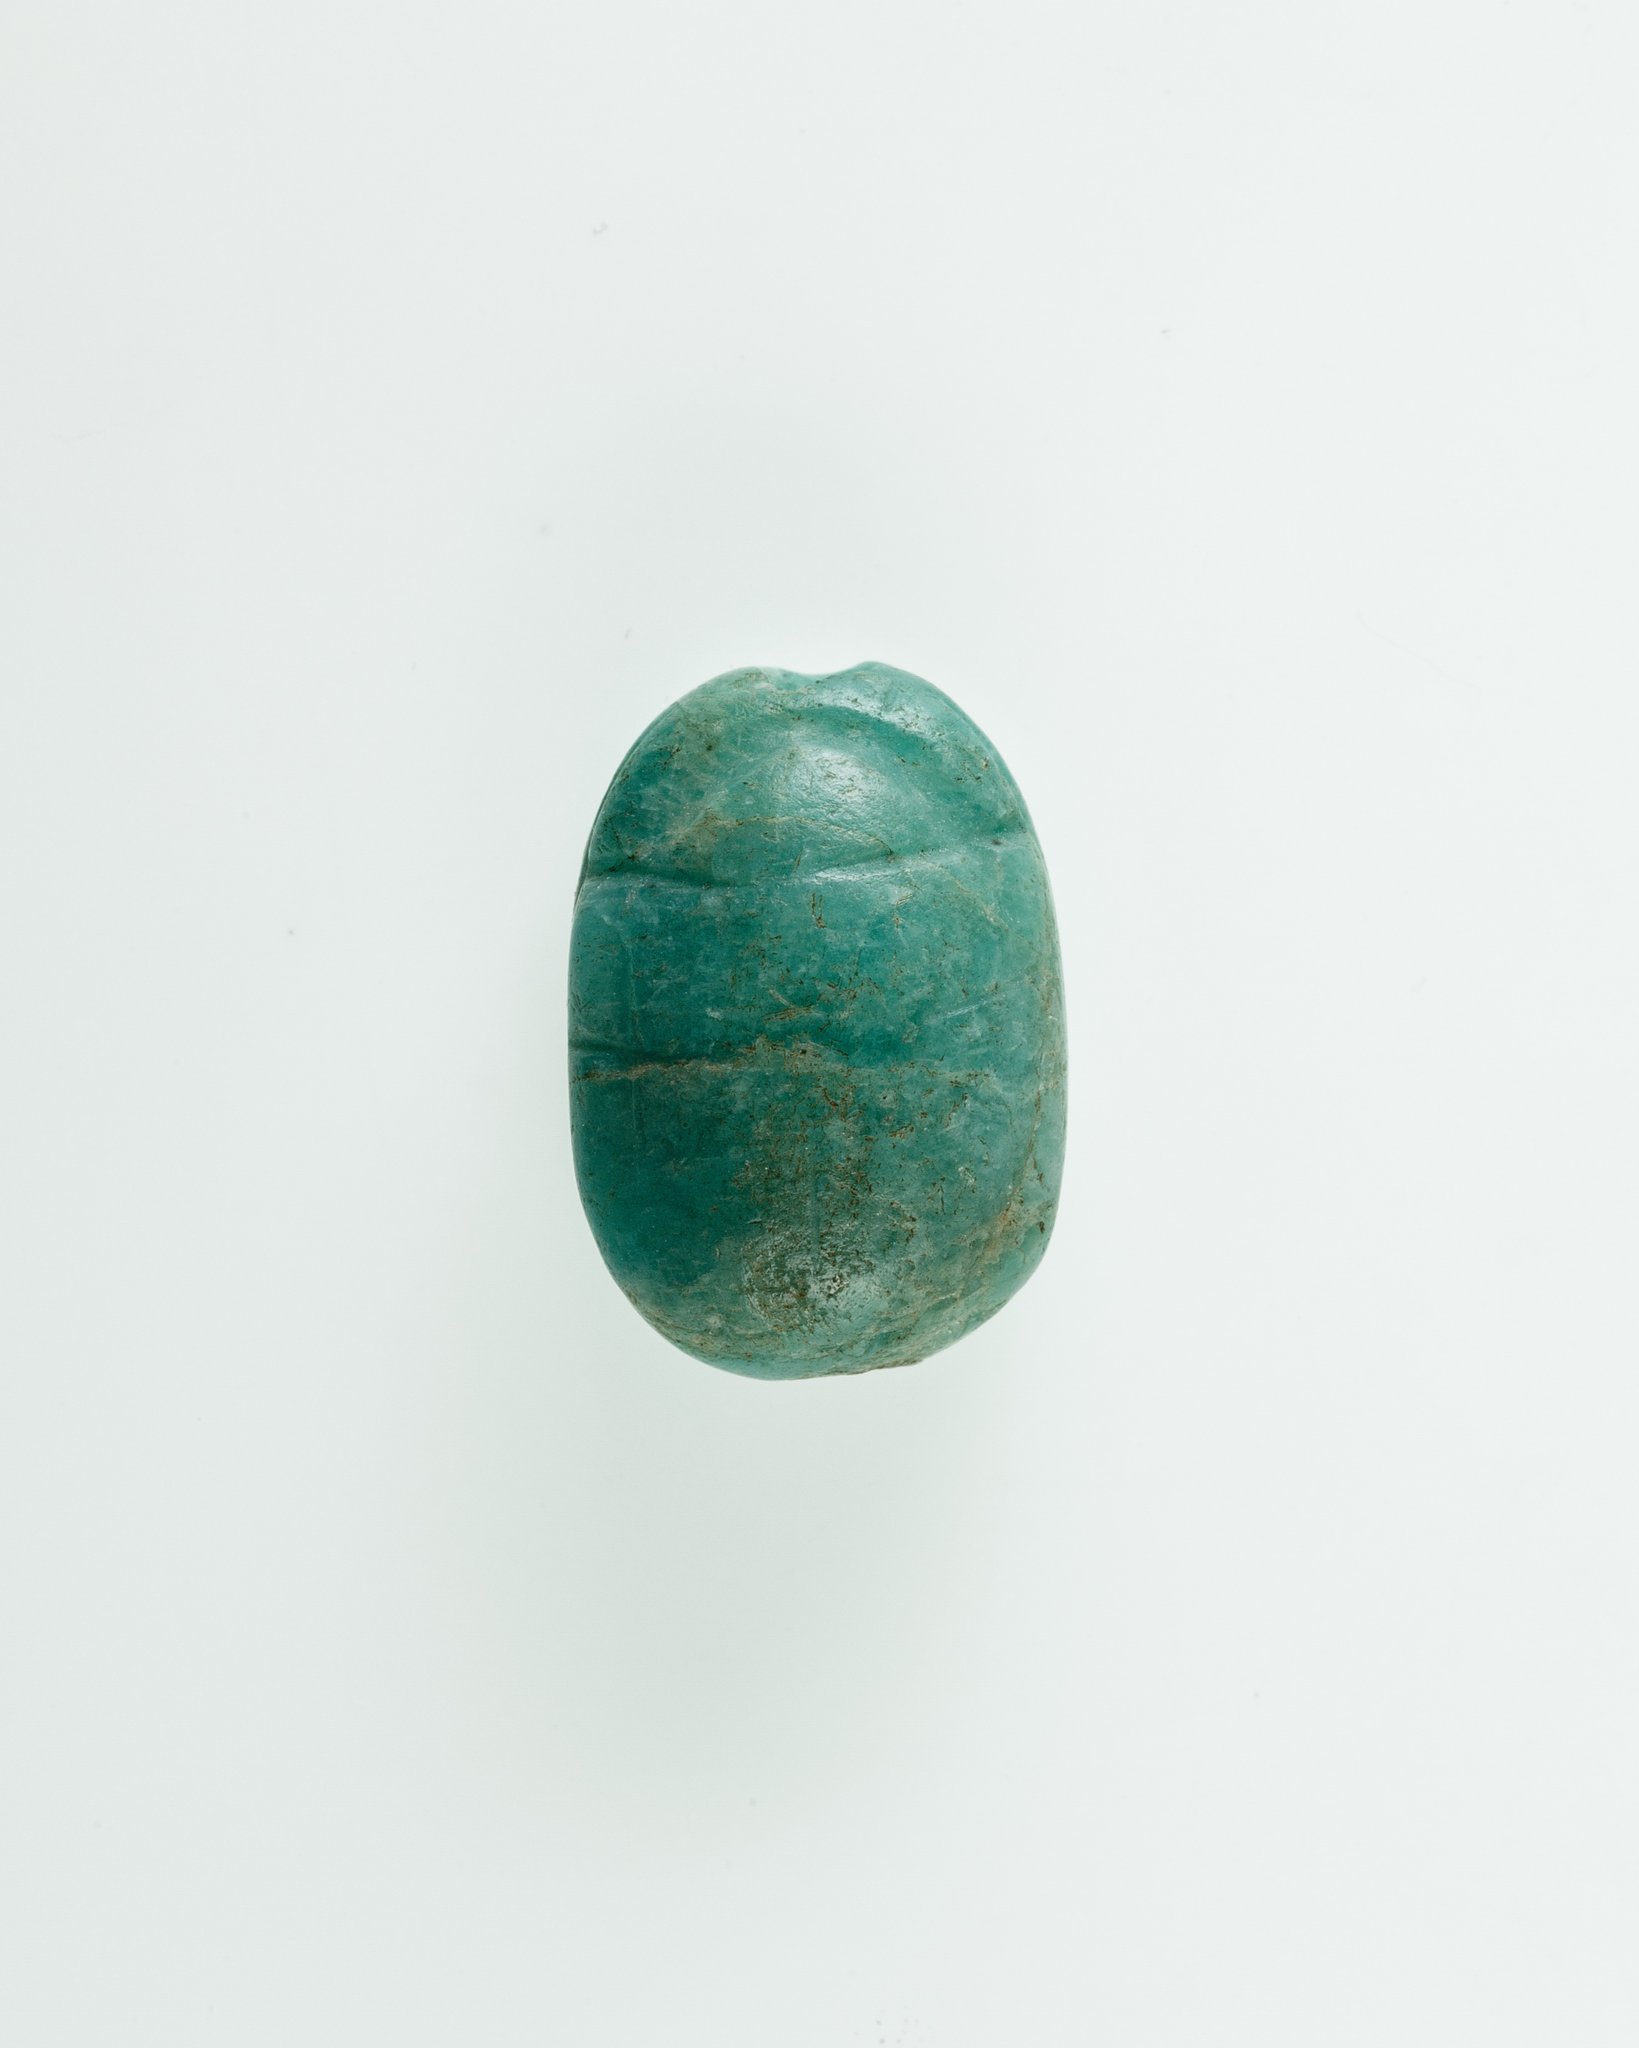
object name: scarab, uninscribed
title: Scarab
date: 1900-1850 BCE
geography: egypt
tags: scarabs